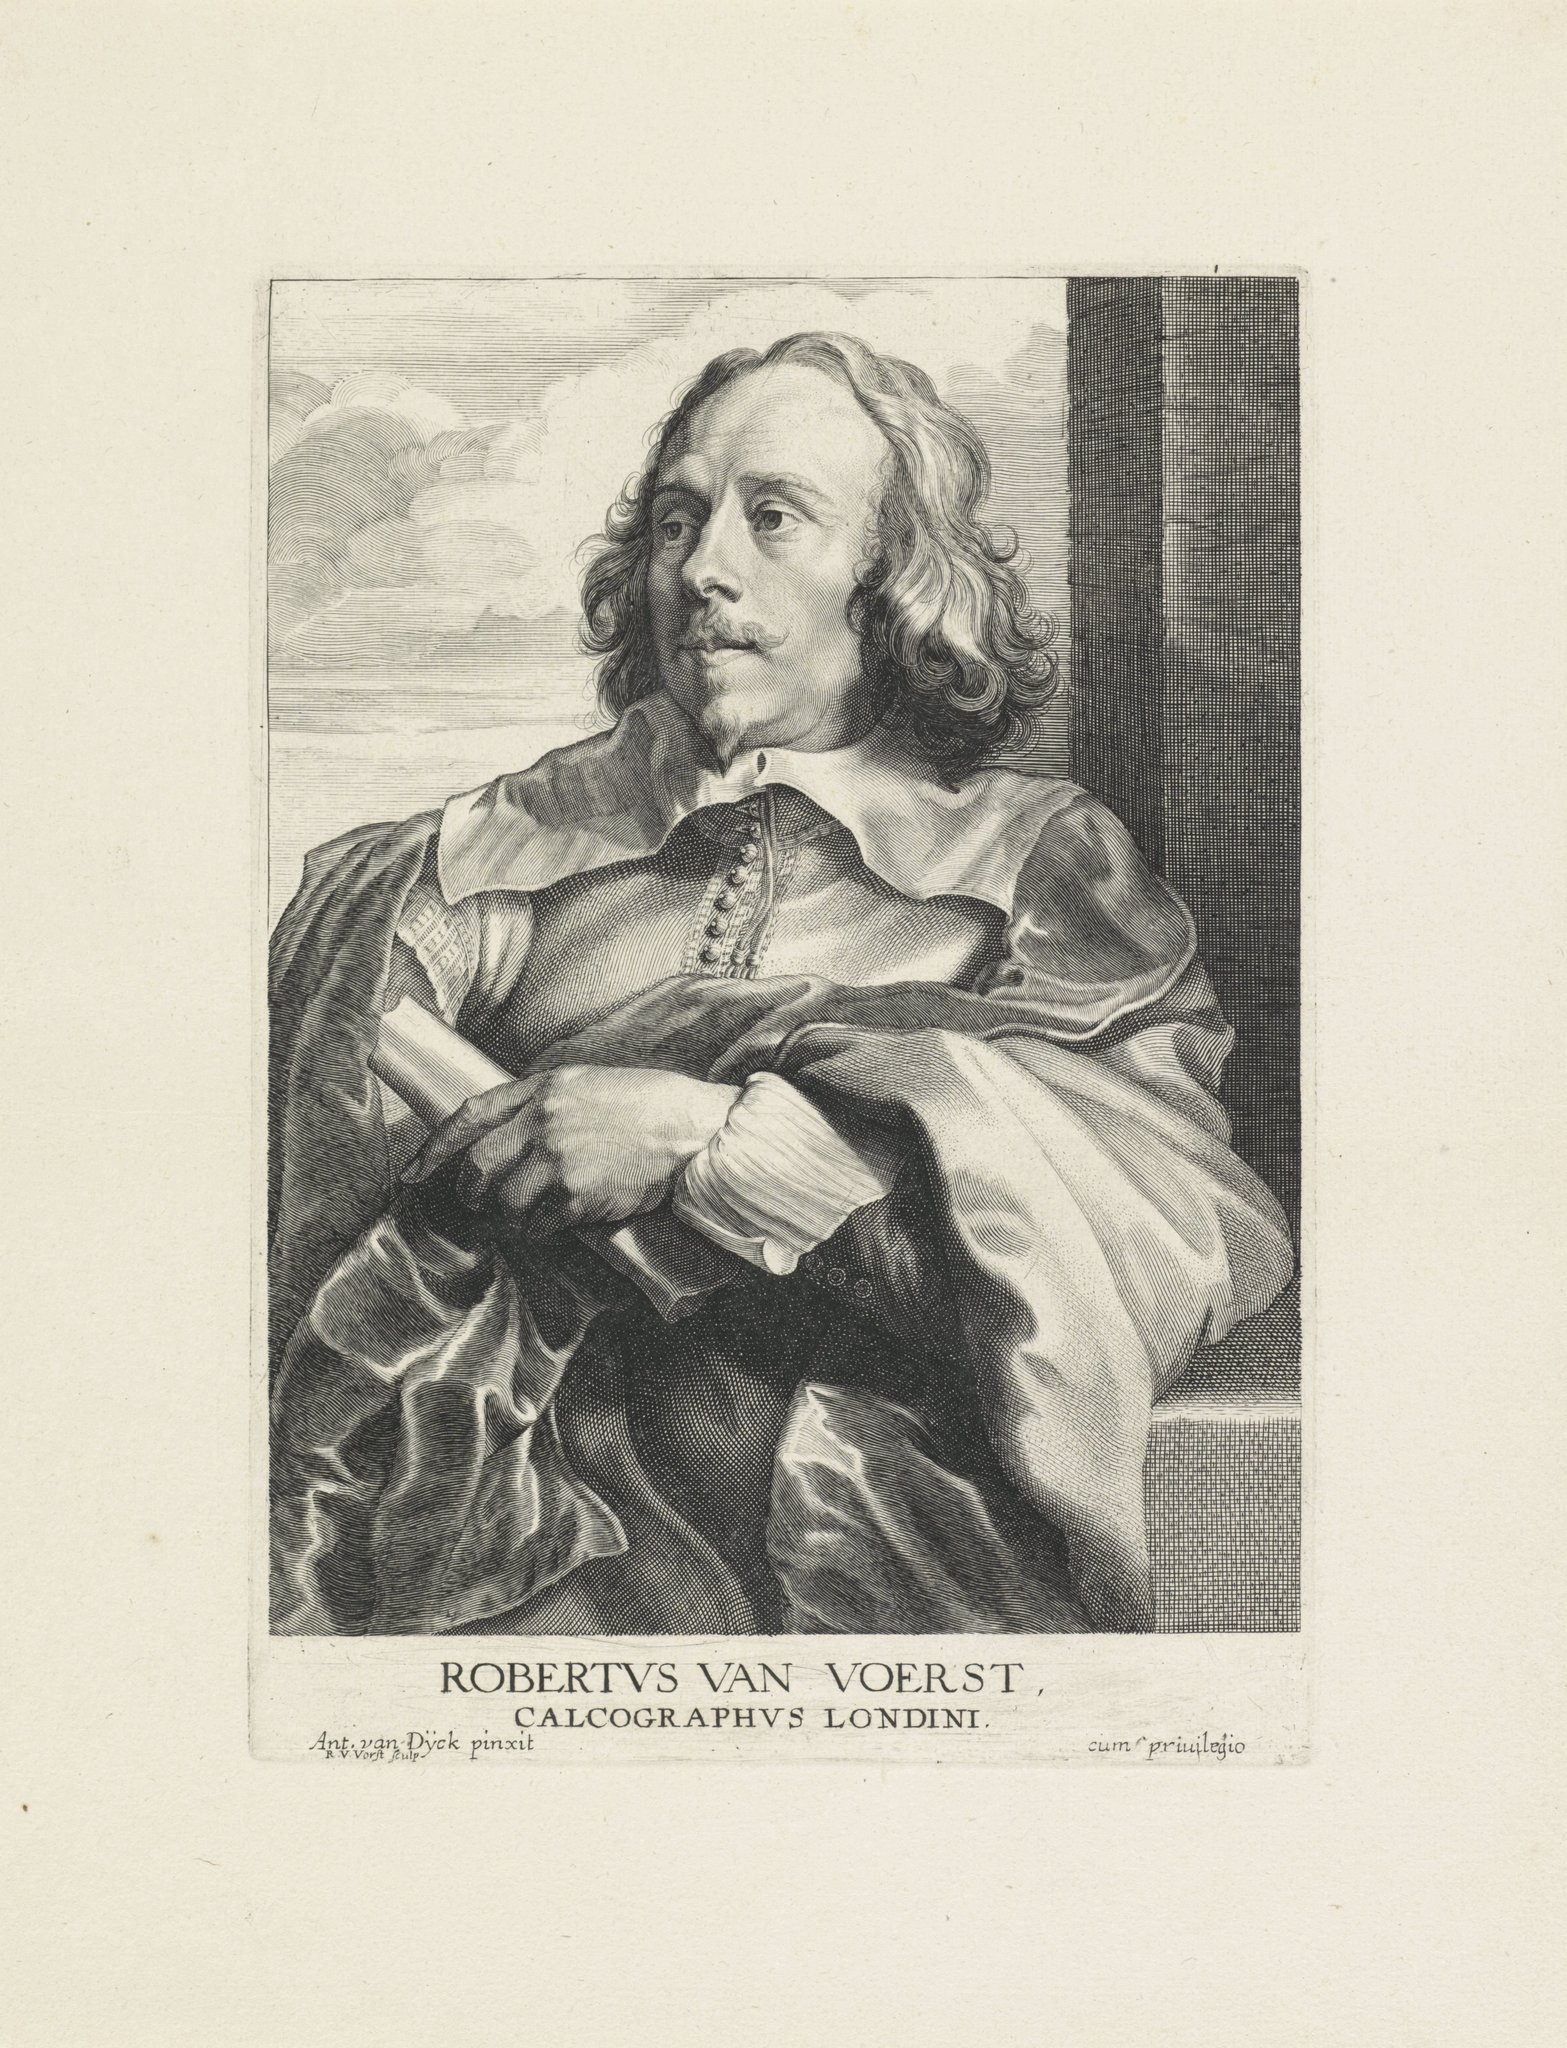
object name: print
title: Portret van Robert van Voerst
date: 1627-1636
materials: paper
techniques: engraving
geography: london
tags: deventer, london, robert van voerst, paper (writing material)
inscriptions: collector's mark: Lugt 2760, collector's mark: Lugt 2166, collector's mark: Lugt 2228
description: Portet van de graveur Robert van Voerst. In zijn hand een rol papier.